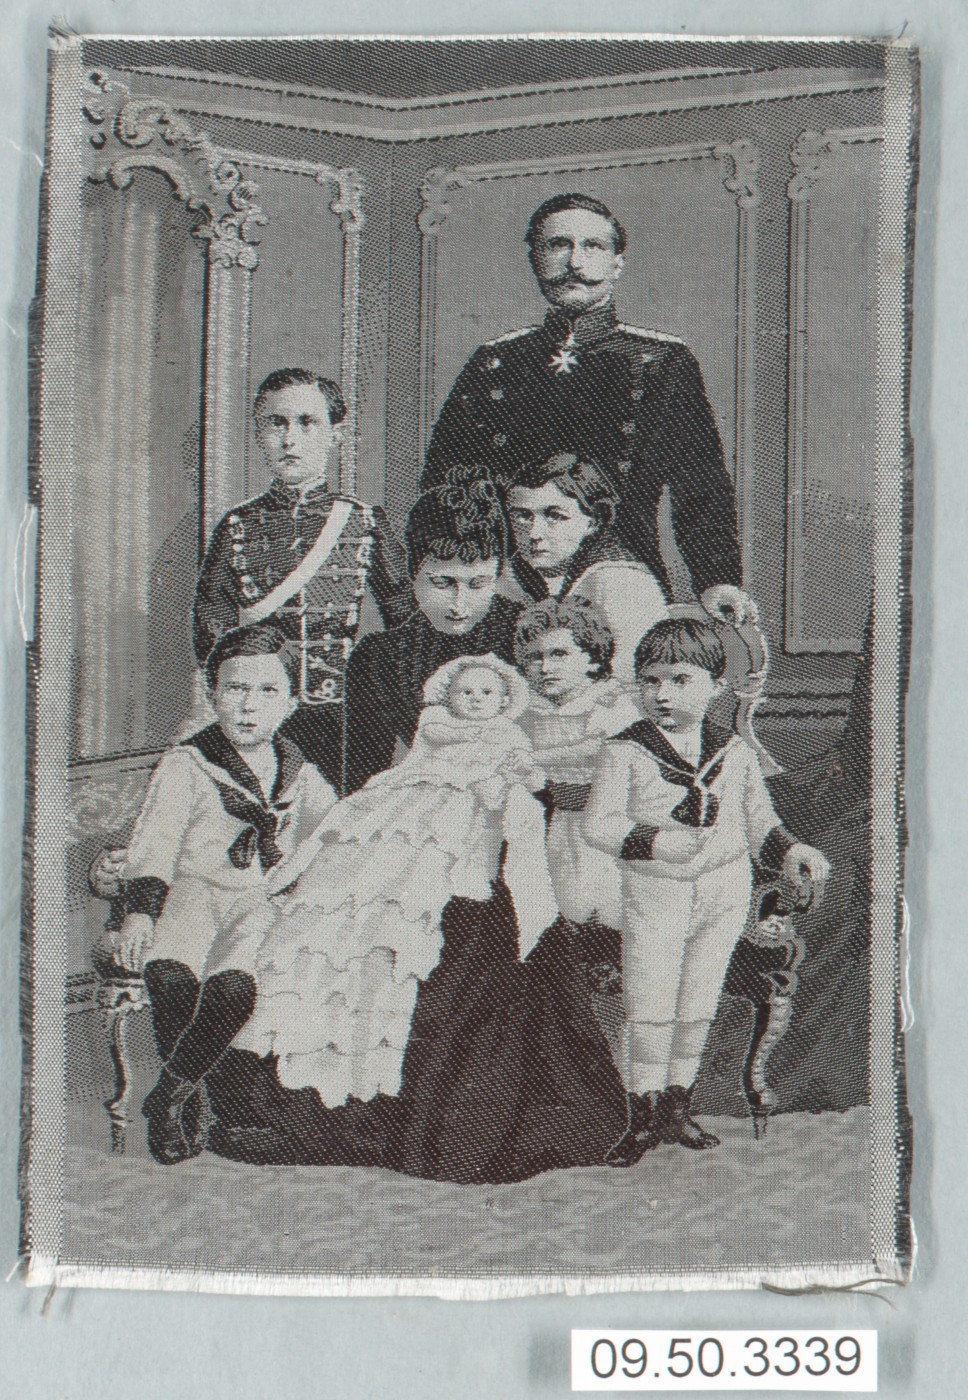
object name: portrait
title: William II, German Emperor (r. 1888–1918) and family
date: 1891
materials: silk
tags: kings,children,women,family